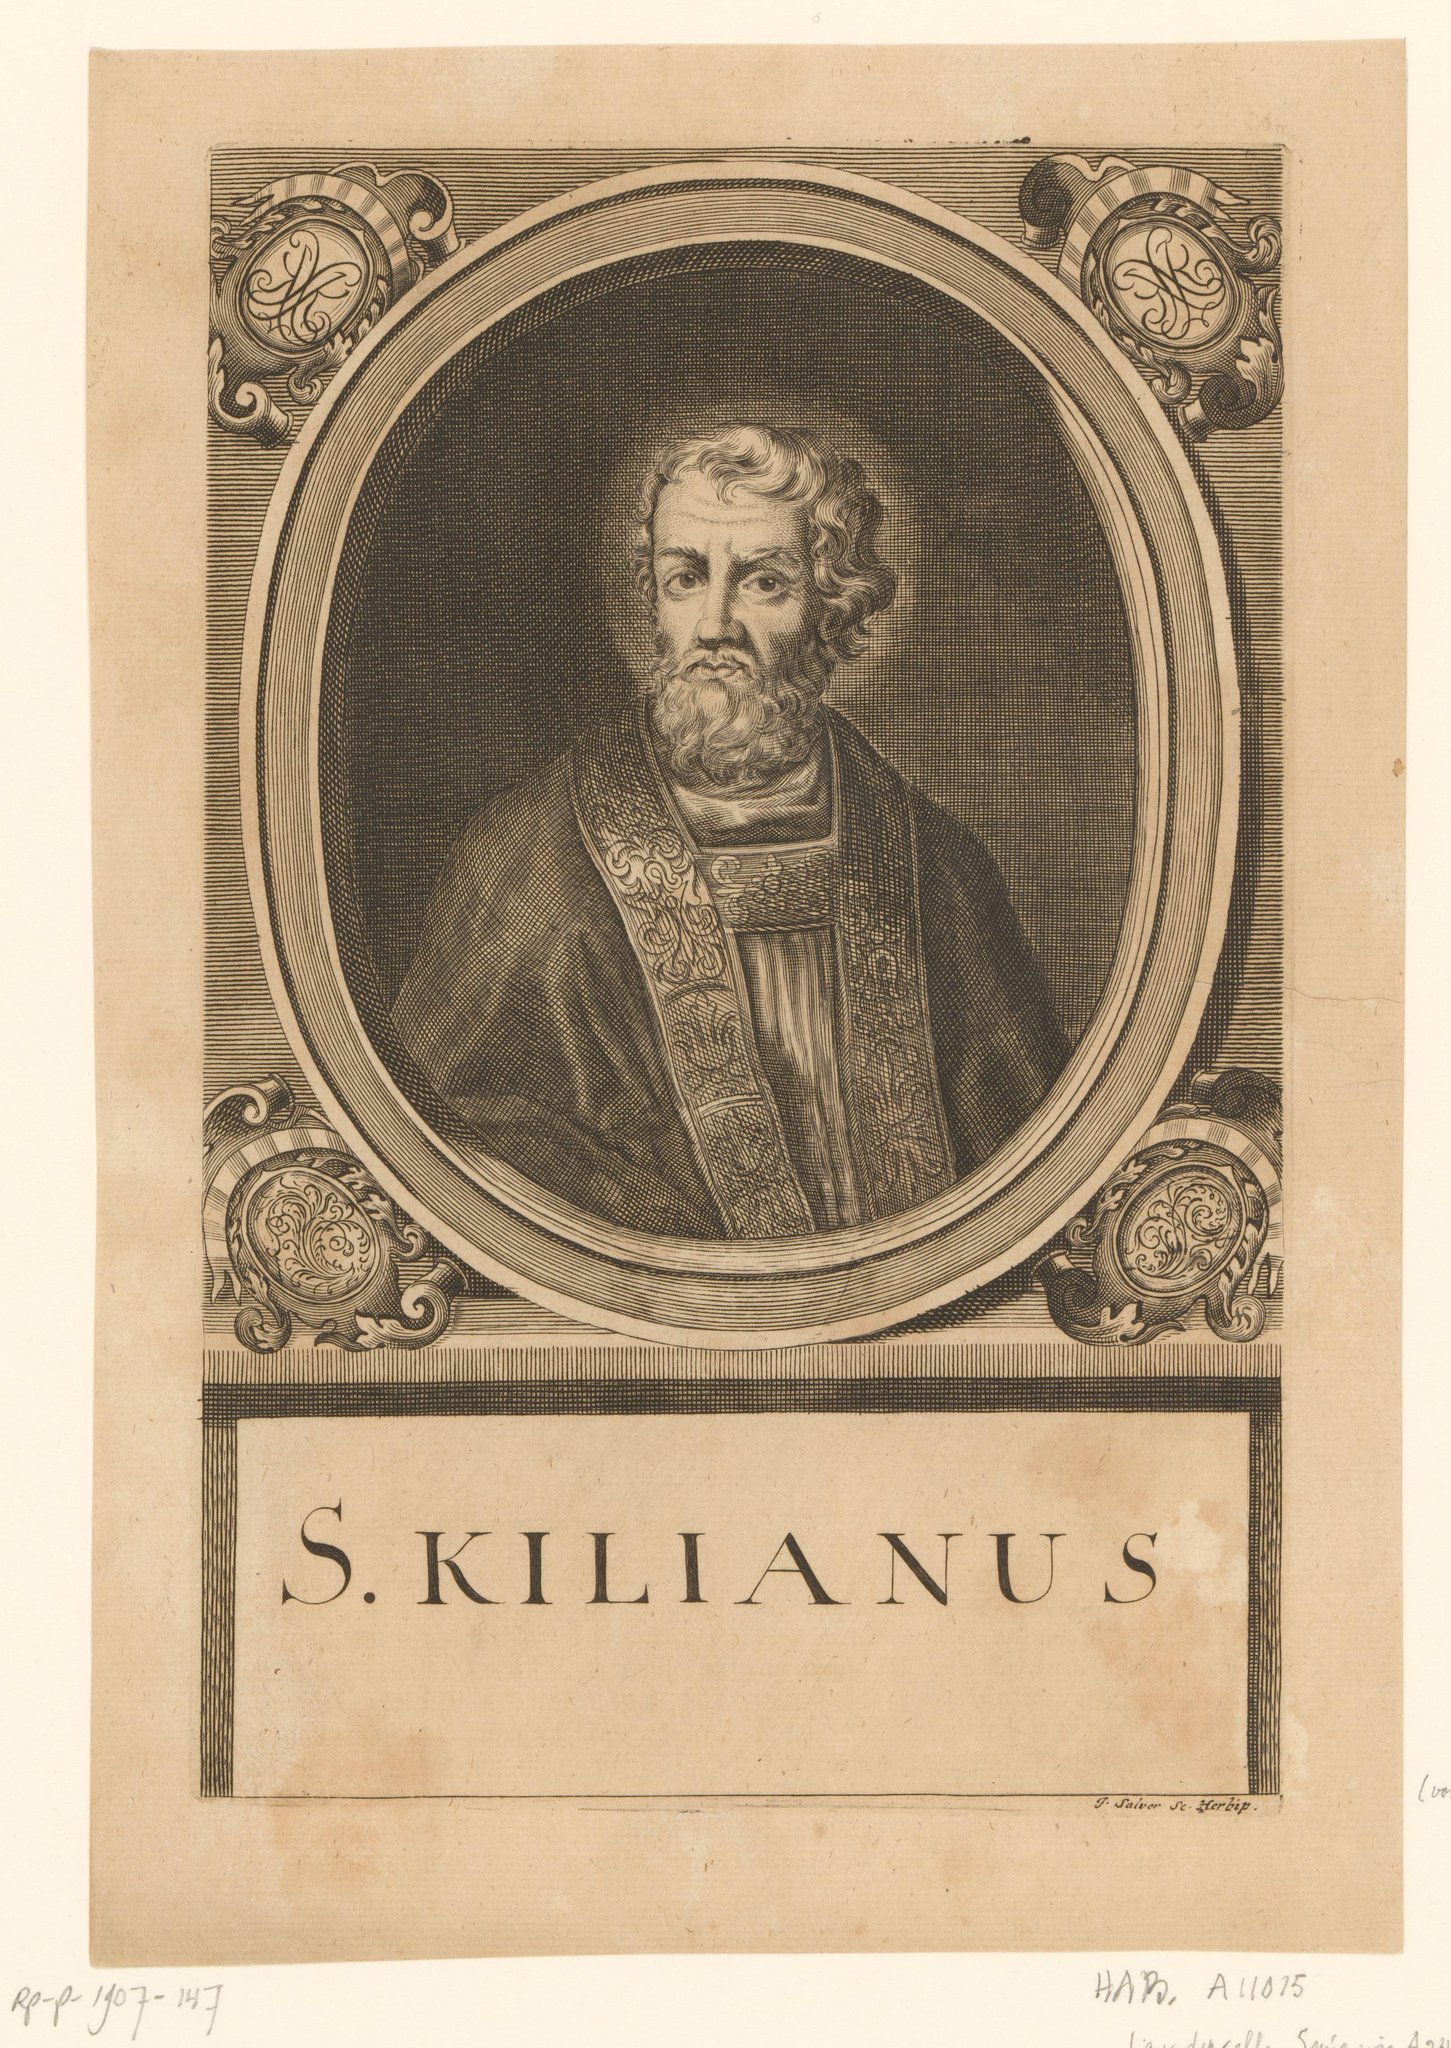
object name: print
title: Portret van Kilian van Würzburg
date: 1713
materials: paper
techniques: engraving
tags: archbishop, bishop, etc. (roman catholic), theologian, historical persons, armorial bearing, heraldry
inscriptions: collector's mark: Lugt 2228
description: Prent ook gebruikt in: Ludewig, Johann Peter von. Geschicht-Schreiber von dem Bischoffthum Wirtzburg. Frankfurt am Main: Thomas Fritsch, 1713.